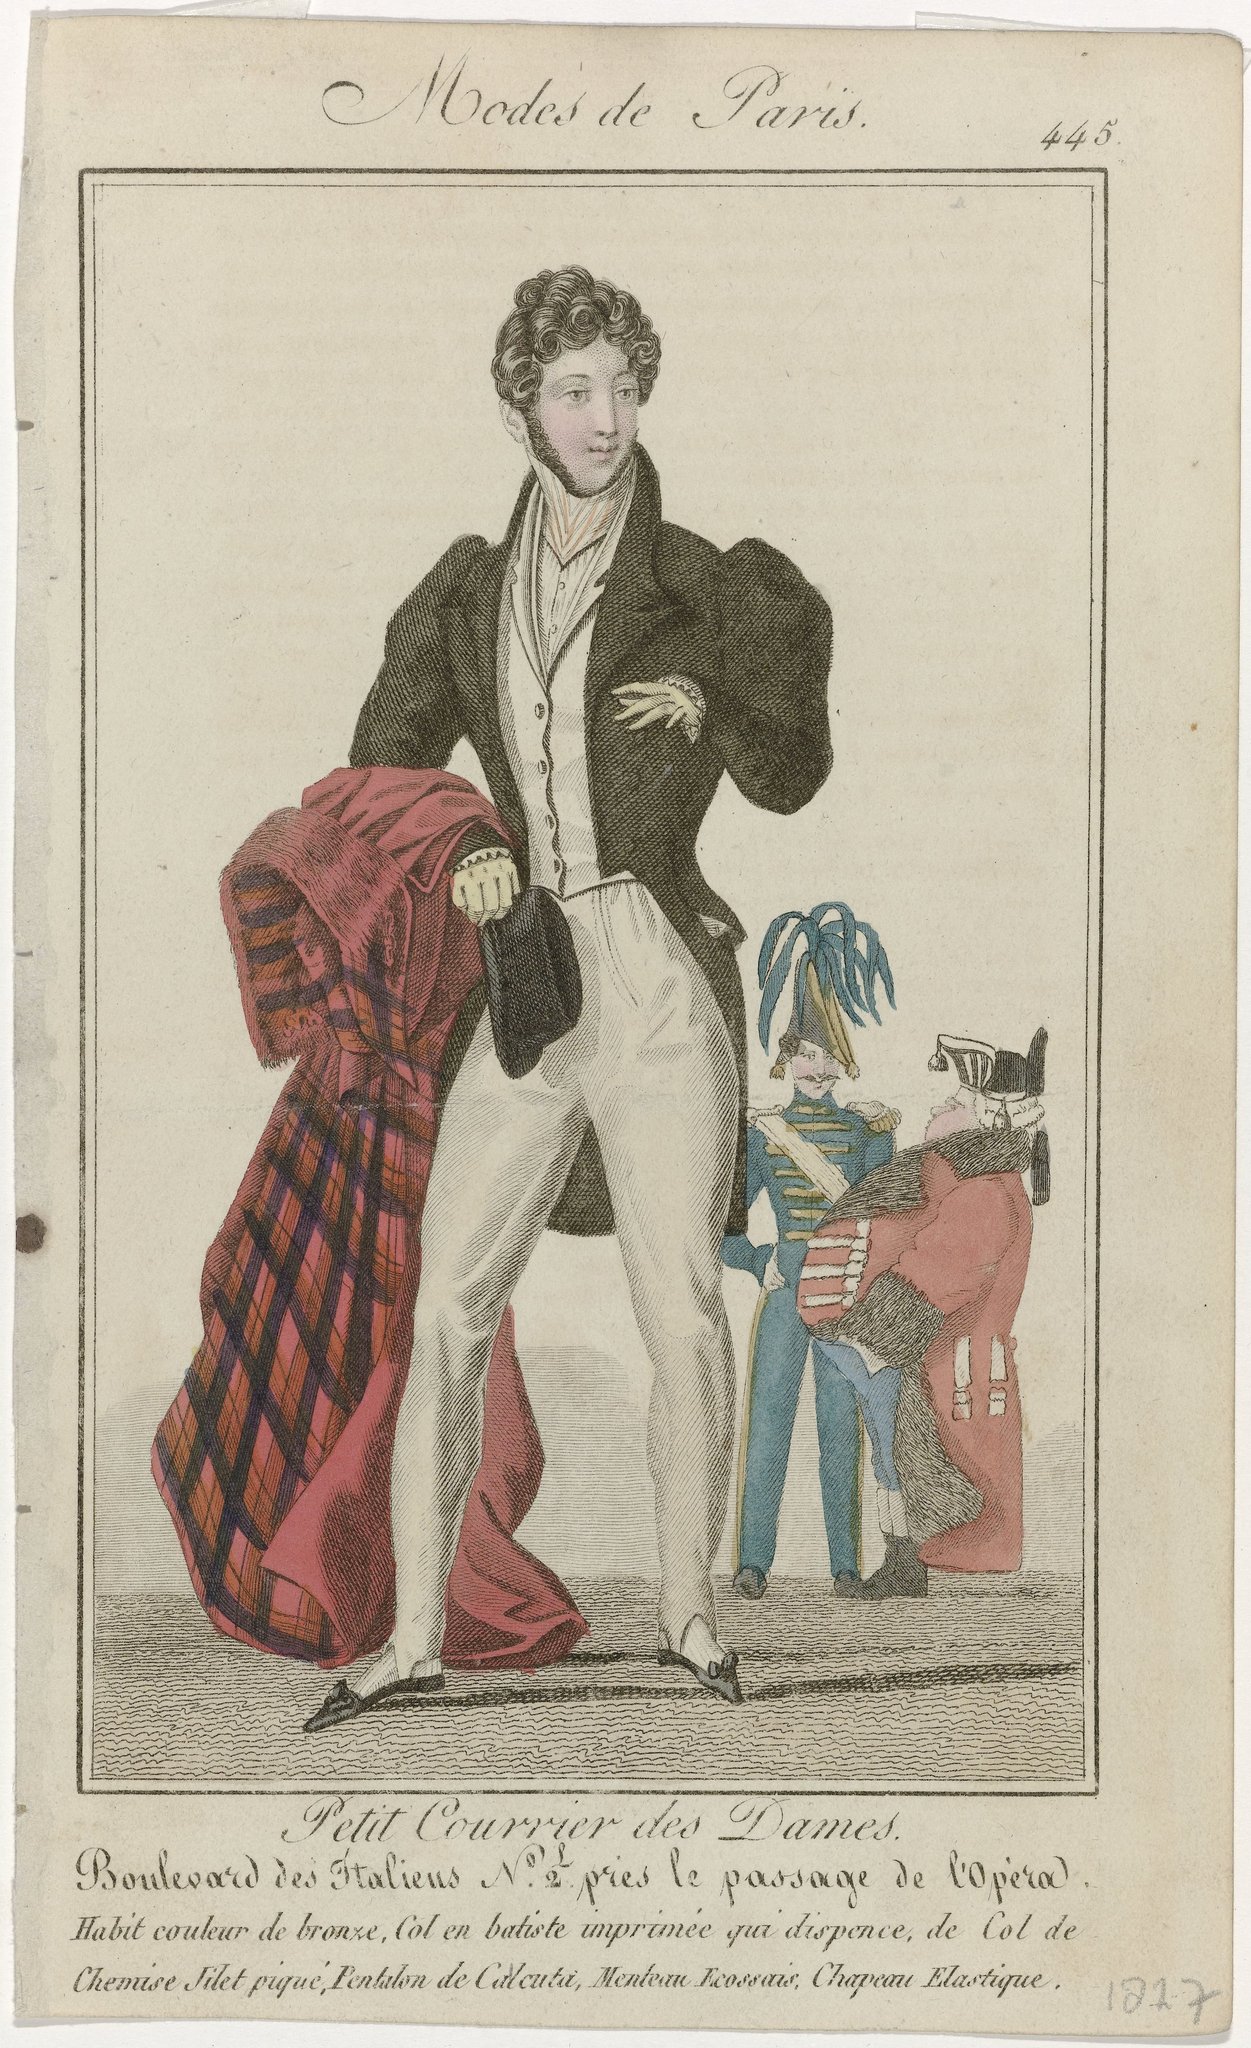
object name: fashion print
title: Petit Courrier des Dames, 1827, No. 445 : Habit couleur de bronz (...)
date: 1827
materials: paper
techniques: engraving, hand coloring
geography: paris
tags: clothing for the upper part of the body (vest) (+ men's clothes), trousers, breeches (+ men's clothes), cape (+ men's clothes), coat (+ men's clothes), head-gear: hat (+ men's clothes), fashion plates, shoes, sandals (+ men's clothes), neck-gear: collar (+ men's clothes), (military) uniforms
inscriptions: title: ‘Petit Courrier des Dames.’, caption: ‘Habit couleur de bronze, Col en batiste imprimée qui dispence, de Col de Chemise Jilet piqué, Pentalon de Calcuta, Menteau Ecossais, Chapeau Elastique.’, title: ‘Modes de Paris.’, address: ‘Boulevard des Italiens No.2 près le passage de l'Opèra.’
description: Bronskleurige 'habit'. Kraag van bedrukte batist, los van de kraag van het hemd. Vest van piqué. Spanbroek of 'pentalon de calcuta'. Schots geruite mantel. Accessoires: hoed of 'chapeau Elastique', handschoenen, platte schoenen met strikken en puntige neuzen. Prent uit het modetijdschrift Petit Courrier des Dames (1821-1868).